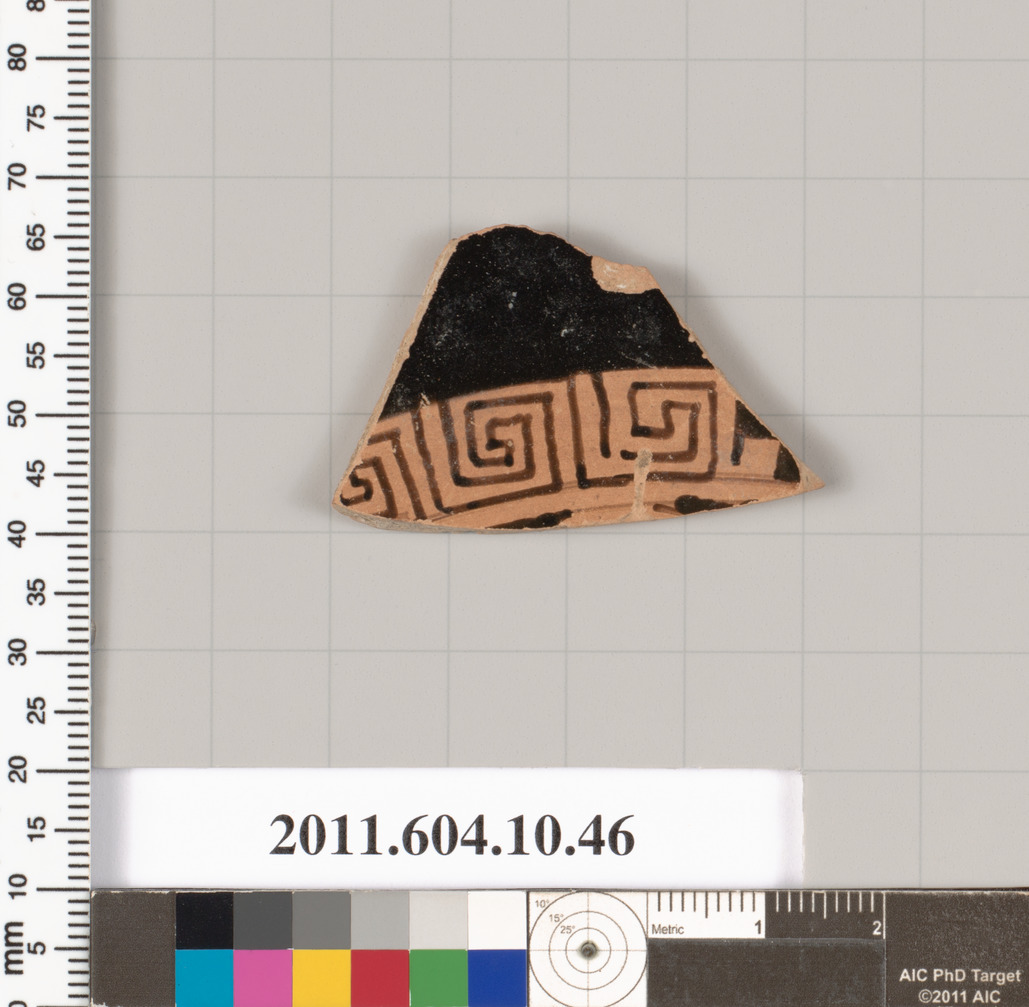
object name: kylix fragment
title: Terracotta fragment of a kylix (drinking cup)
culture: etruscan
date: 334-301 BCE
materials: terracotta